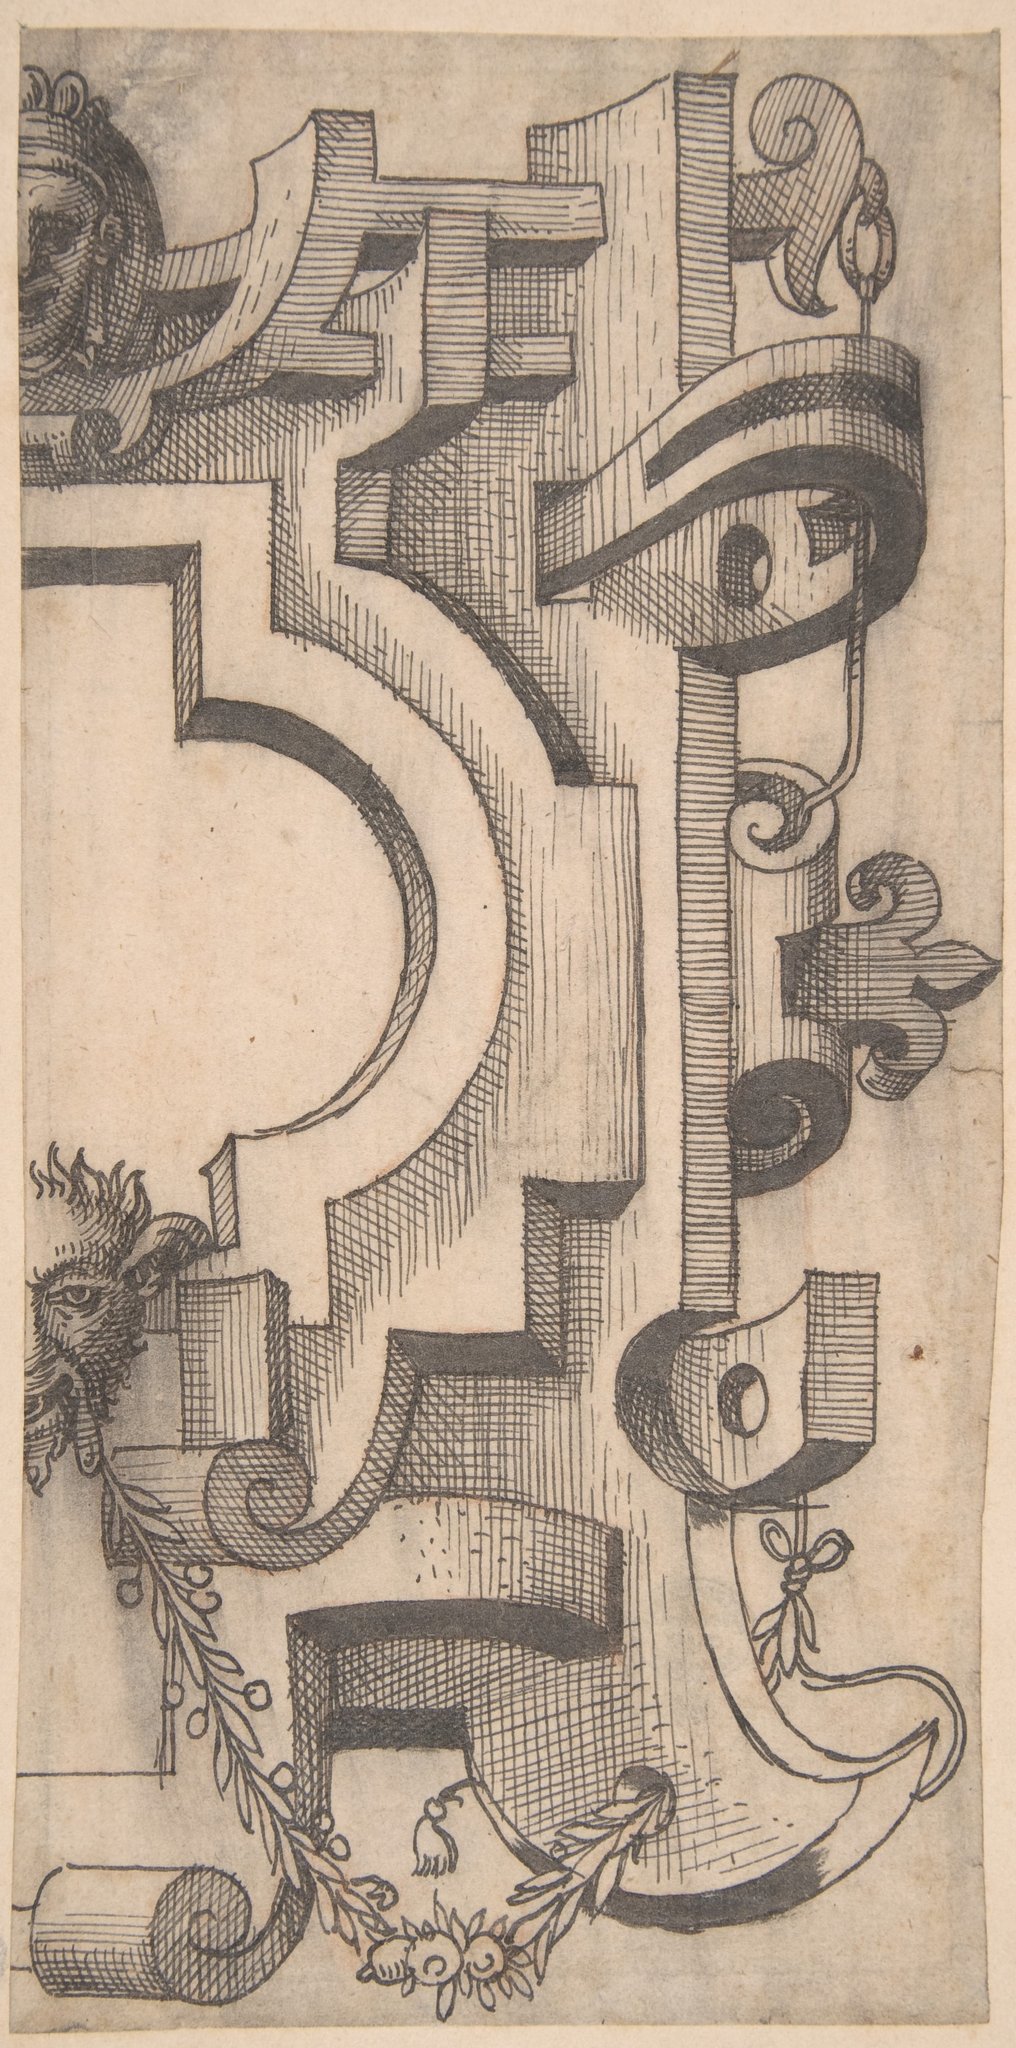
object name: drawing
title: Right Half of a Strapwork Cartouche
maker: anonymous, netherlandish, 16th century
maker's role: artist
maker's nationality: netherlandish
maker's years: 1500-1600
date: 1501-1600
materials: ink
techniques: pen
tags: ornament